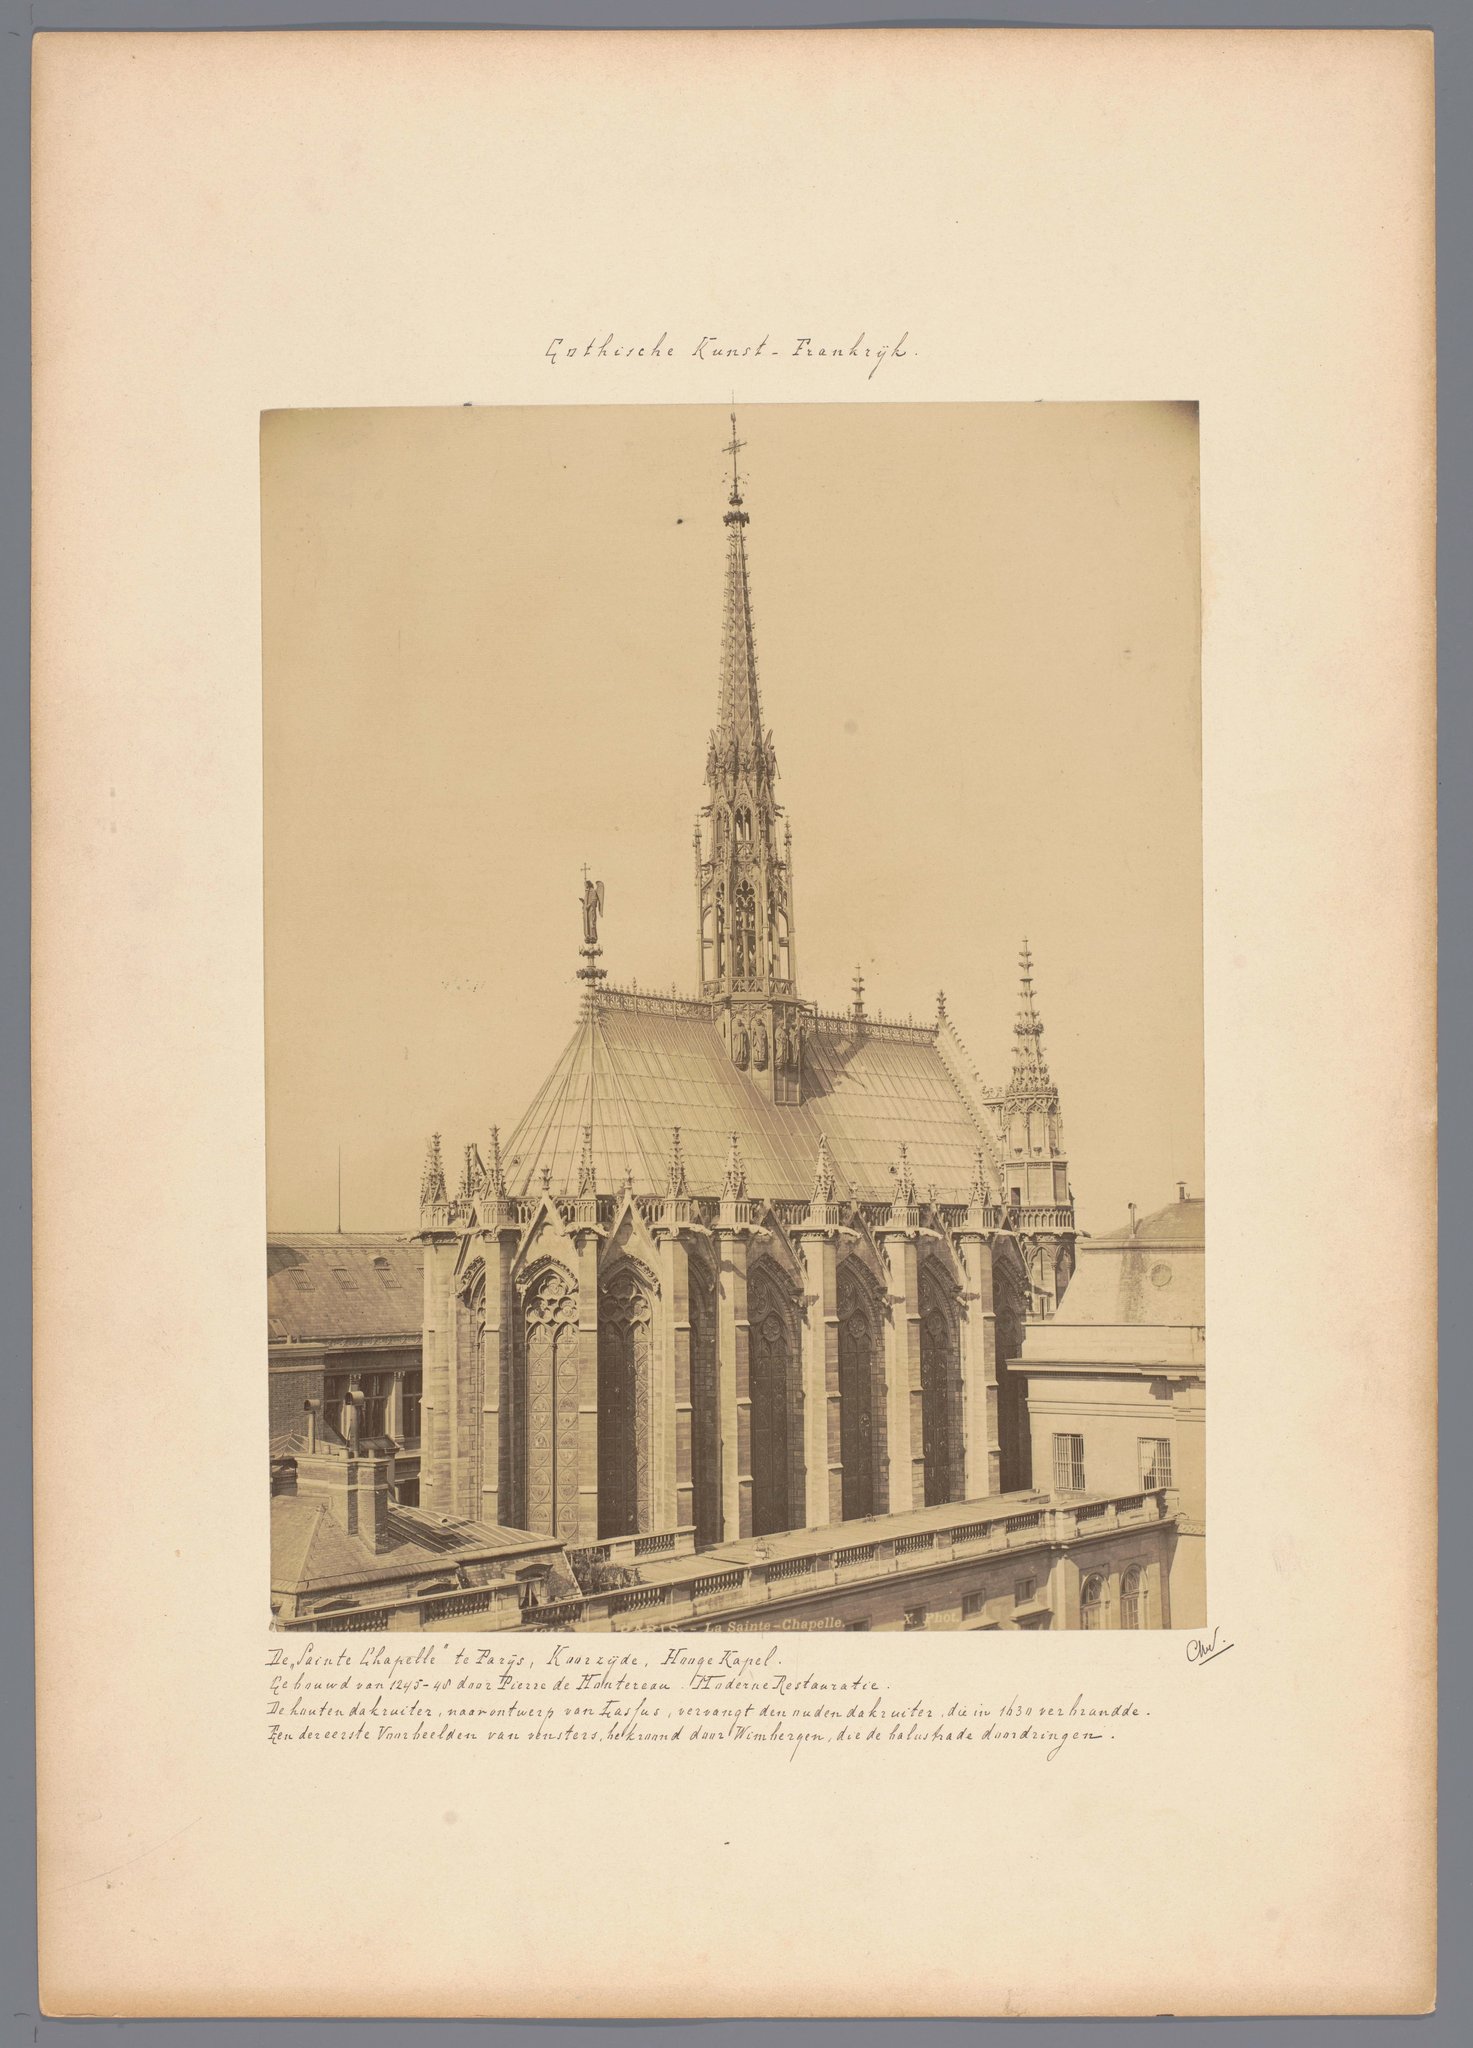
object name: photograph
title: Gezicht op de Sainte-Chapelle te Parijs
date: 1875-1900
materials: cardboard, photographic support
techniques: albumen print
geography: paris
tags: parts of church exterior and annexes: chapel, tower, clock tower ~ monumental adornment, façade (of house or building)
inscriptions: collector's mark: ‘KUNSTNIJVERHEIDSCHOOL QUELLINUS AMSTERDAM FRANS HALSSTRAAT 14.’, number: ‘1945’, collector's mark: ‘INSTITUUT VOOR KUNST- NIJVERHEIDSONDERWIJS GABRIËL METSUSTRAAT No. 16. AMSTERDAM’, inscription: ‘CWN.’, inscription: ‘Gothische Kunst - Frankrijk. De ,,Sainte Chapelle'' te Parijs (...) die de balustrade doordringen.’